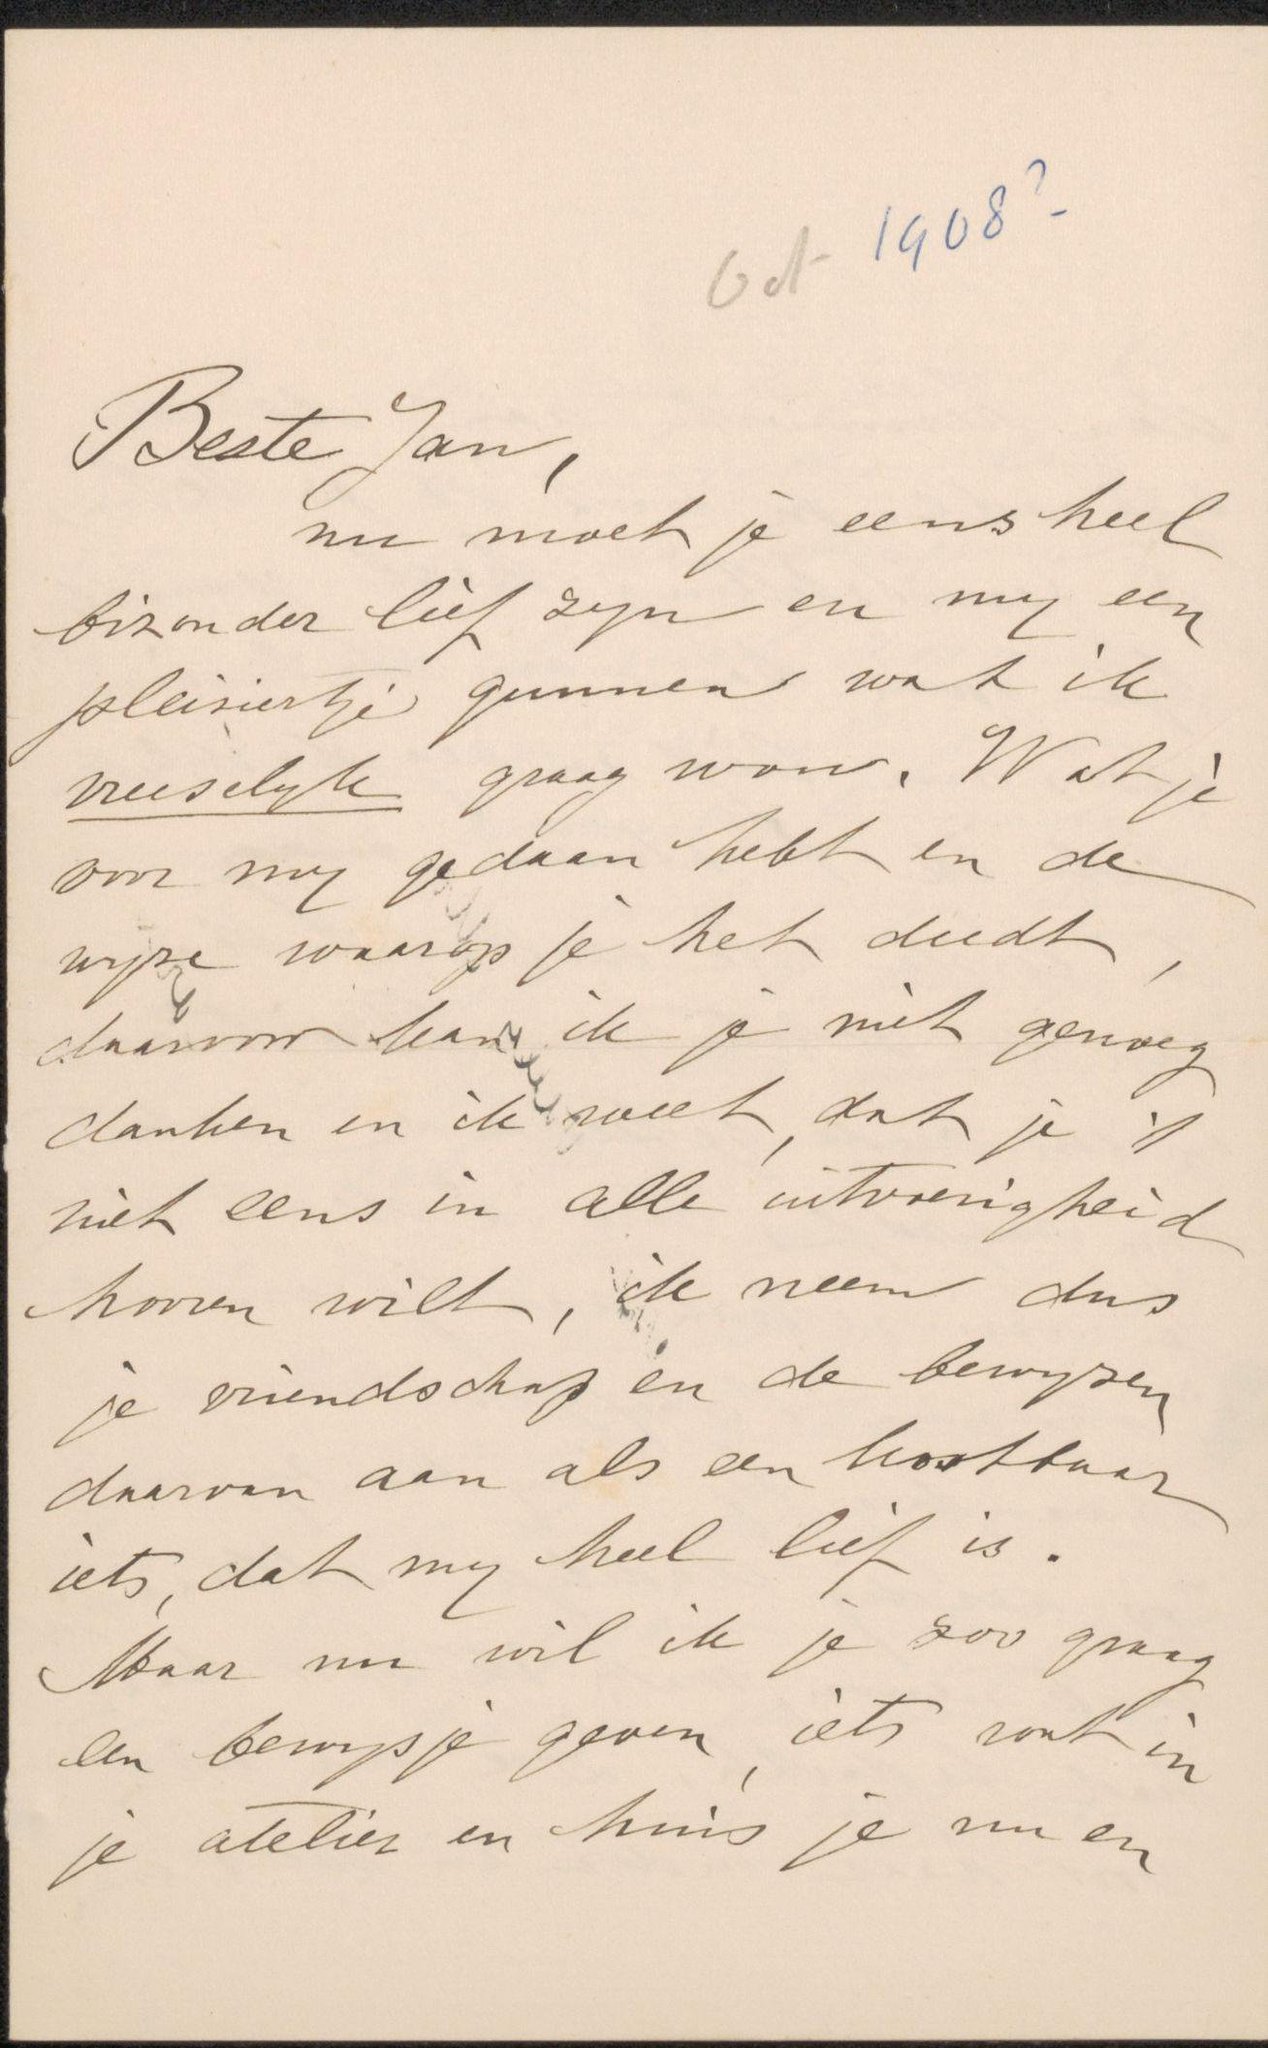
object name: letter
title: Brief aan Jan Veth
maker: wally moes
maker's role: draughtsman, print maker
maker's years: 1856-1918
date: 1891-1918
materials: ink, paper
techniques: pen, writing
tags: rotterdam, george hendrik breitner, dordrecht, designer, jan veth, arnhem, painter, anton mauve, artist, anna dorothea dirks, family life, painting (including book-illumination, miniature-painting)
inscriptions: collector's mark: ‘RPK’